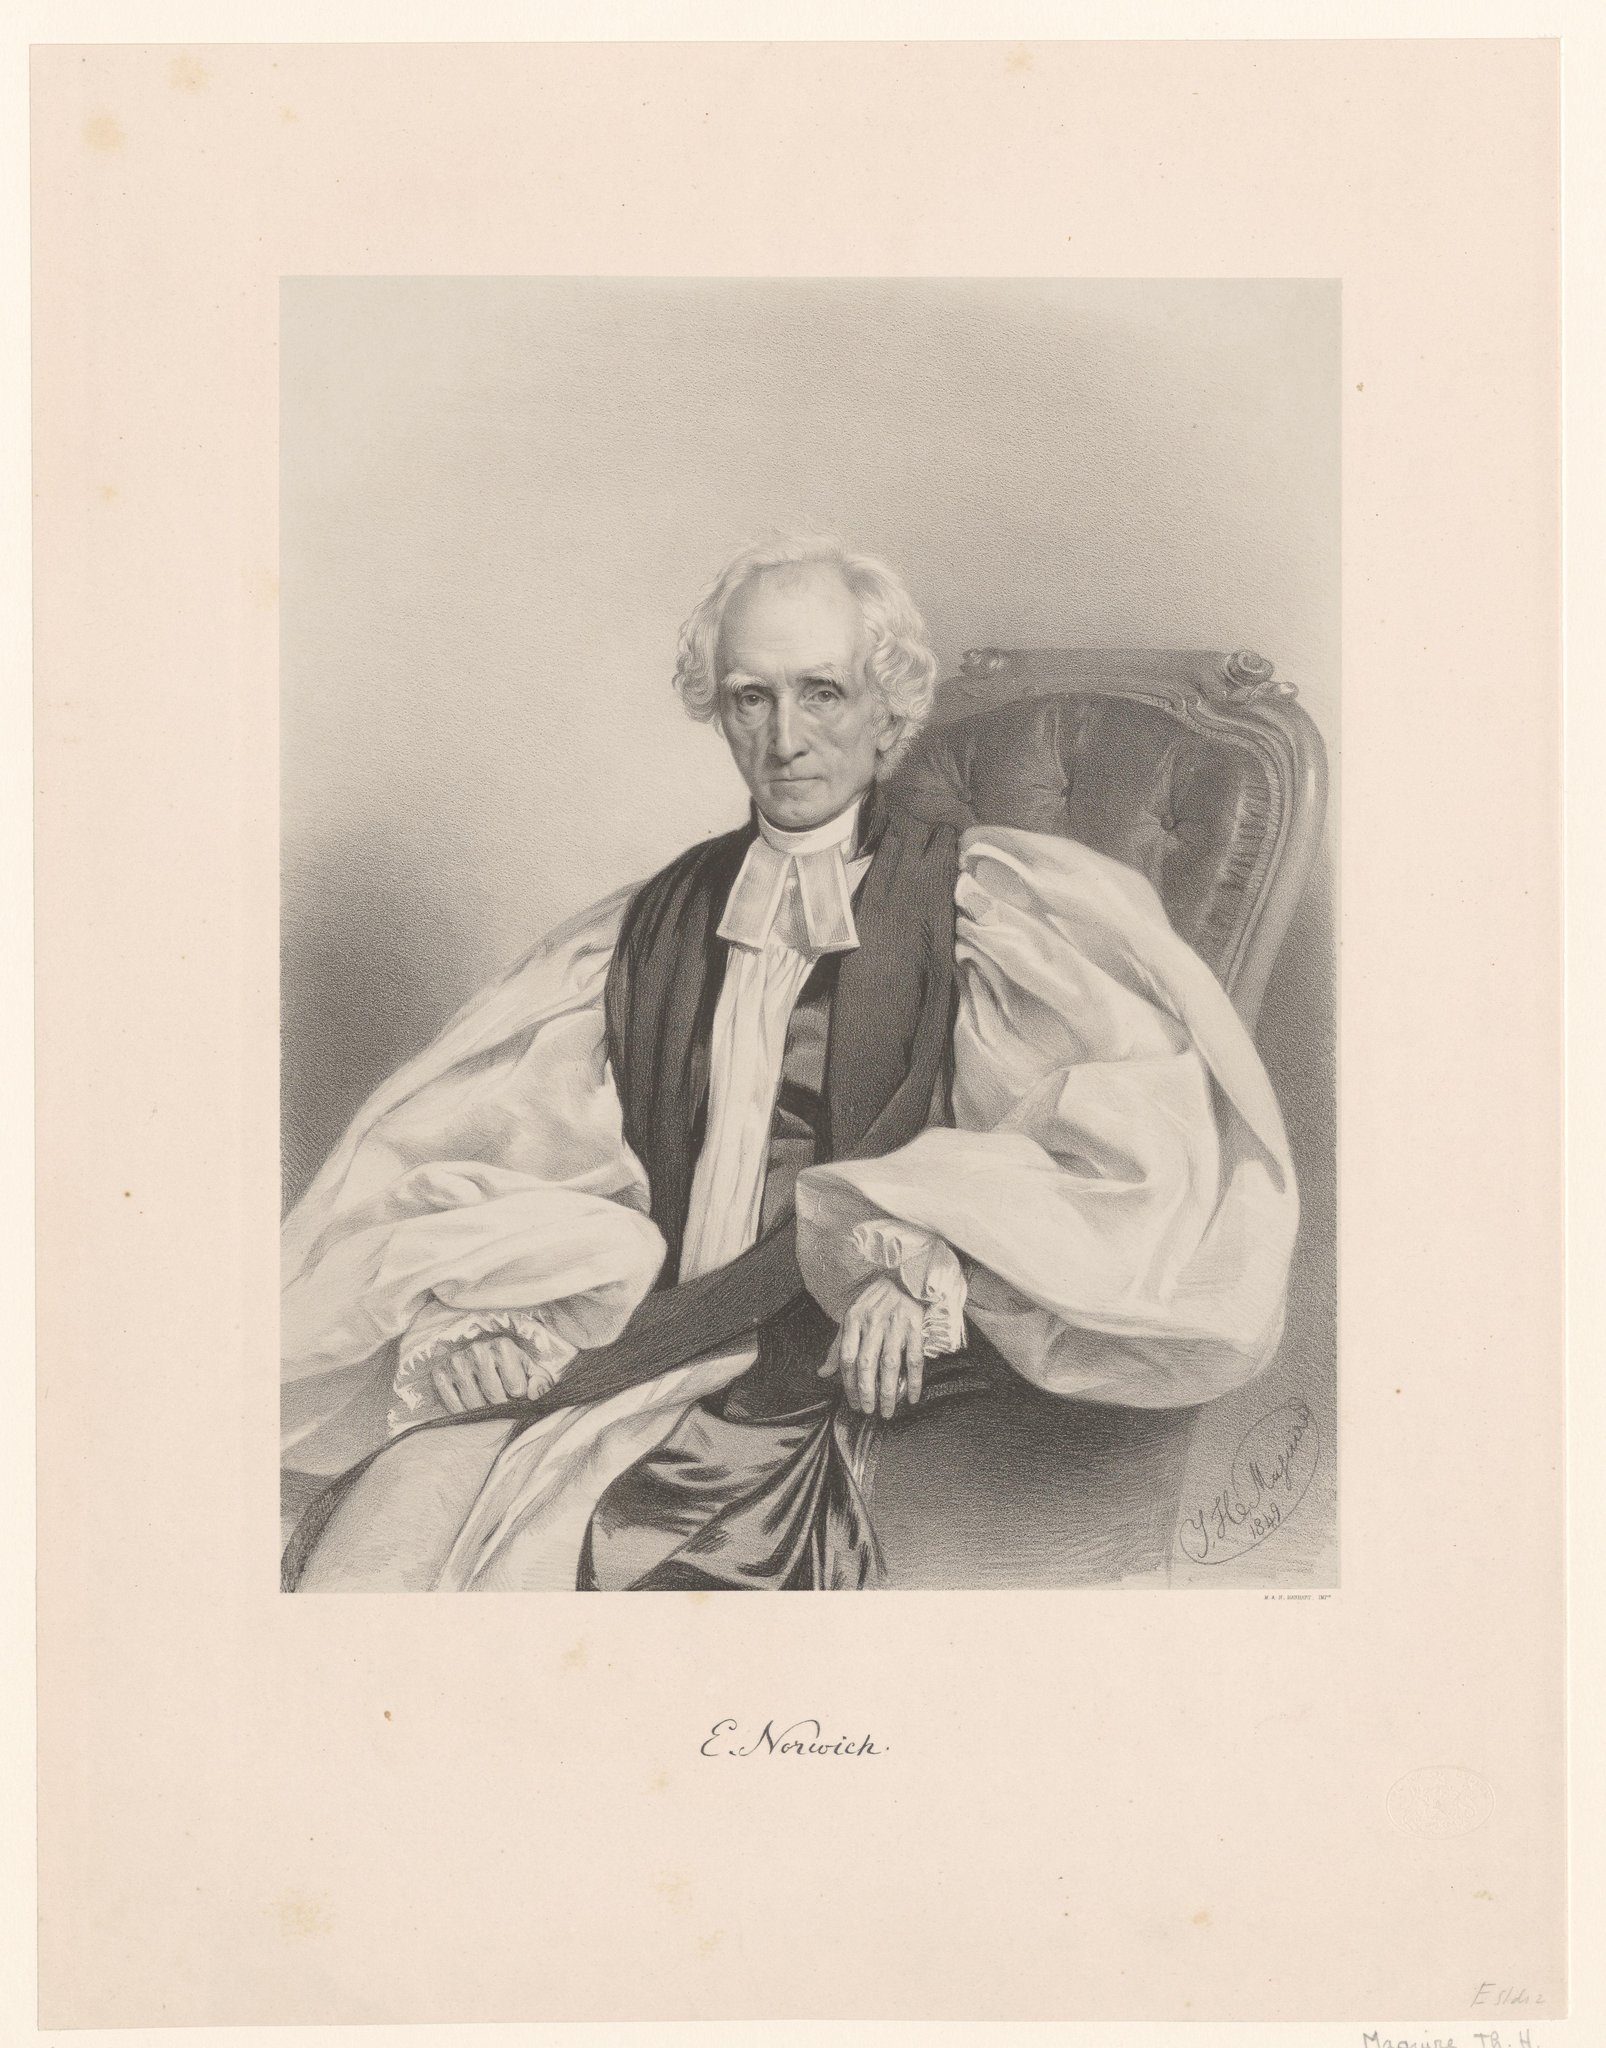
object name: print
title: Portretten uit het Ipswich Museum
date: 1852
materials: paper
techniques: lithograph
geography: london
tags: hierarchy of jurisdiction ~ roman catholic church, adult man, historical persons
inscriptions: check stamp: ‘Ipswich Museum’, collector's mark: Lugt 2228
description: Prent behoort tot de serie 'Ipswich Museum Portraits', ook bekend onder de titel 'Portraits of Honorary Members of the Ipswich Museum'. Deze serie is in 1852 door George Ransome uitgegeven en gedrukt door M&N Hanhart tussen 1848 en 1852. De serie bestaat uit ca. 60 portretten.